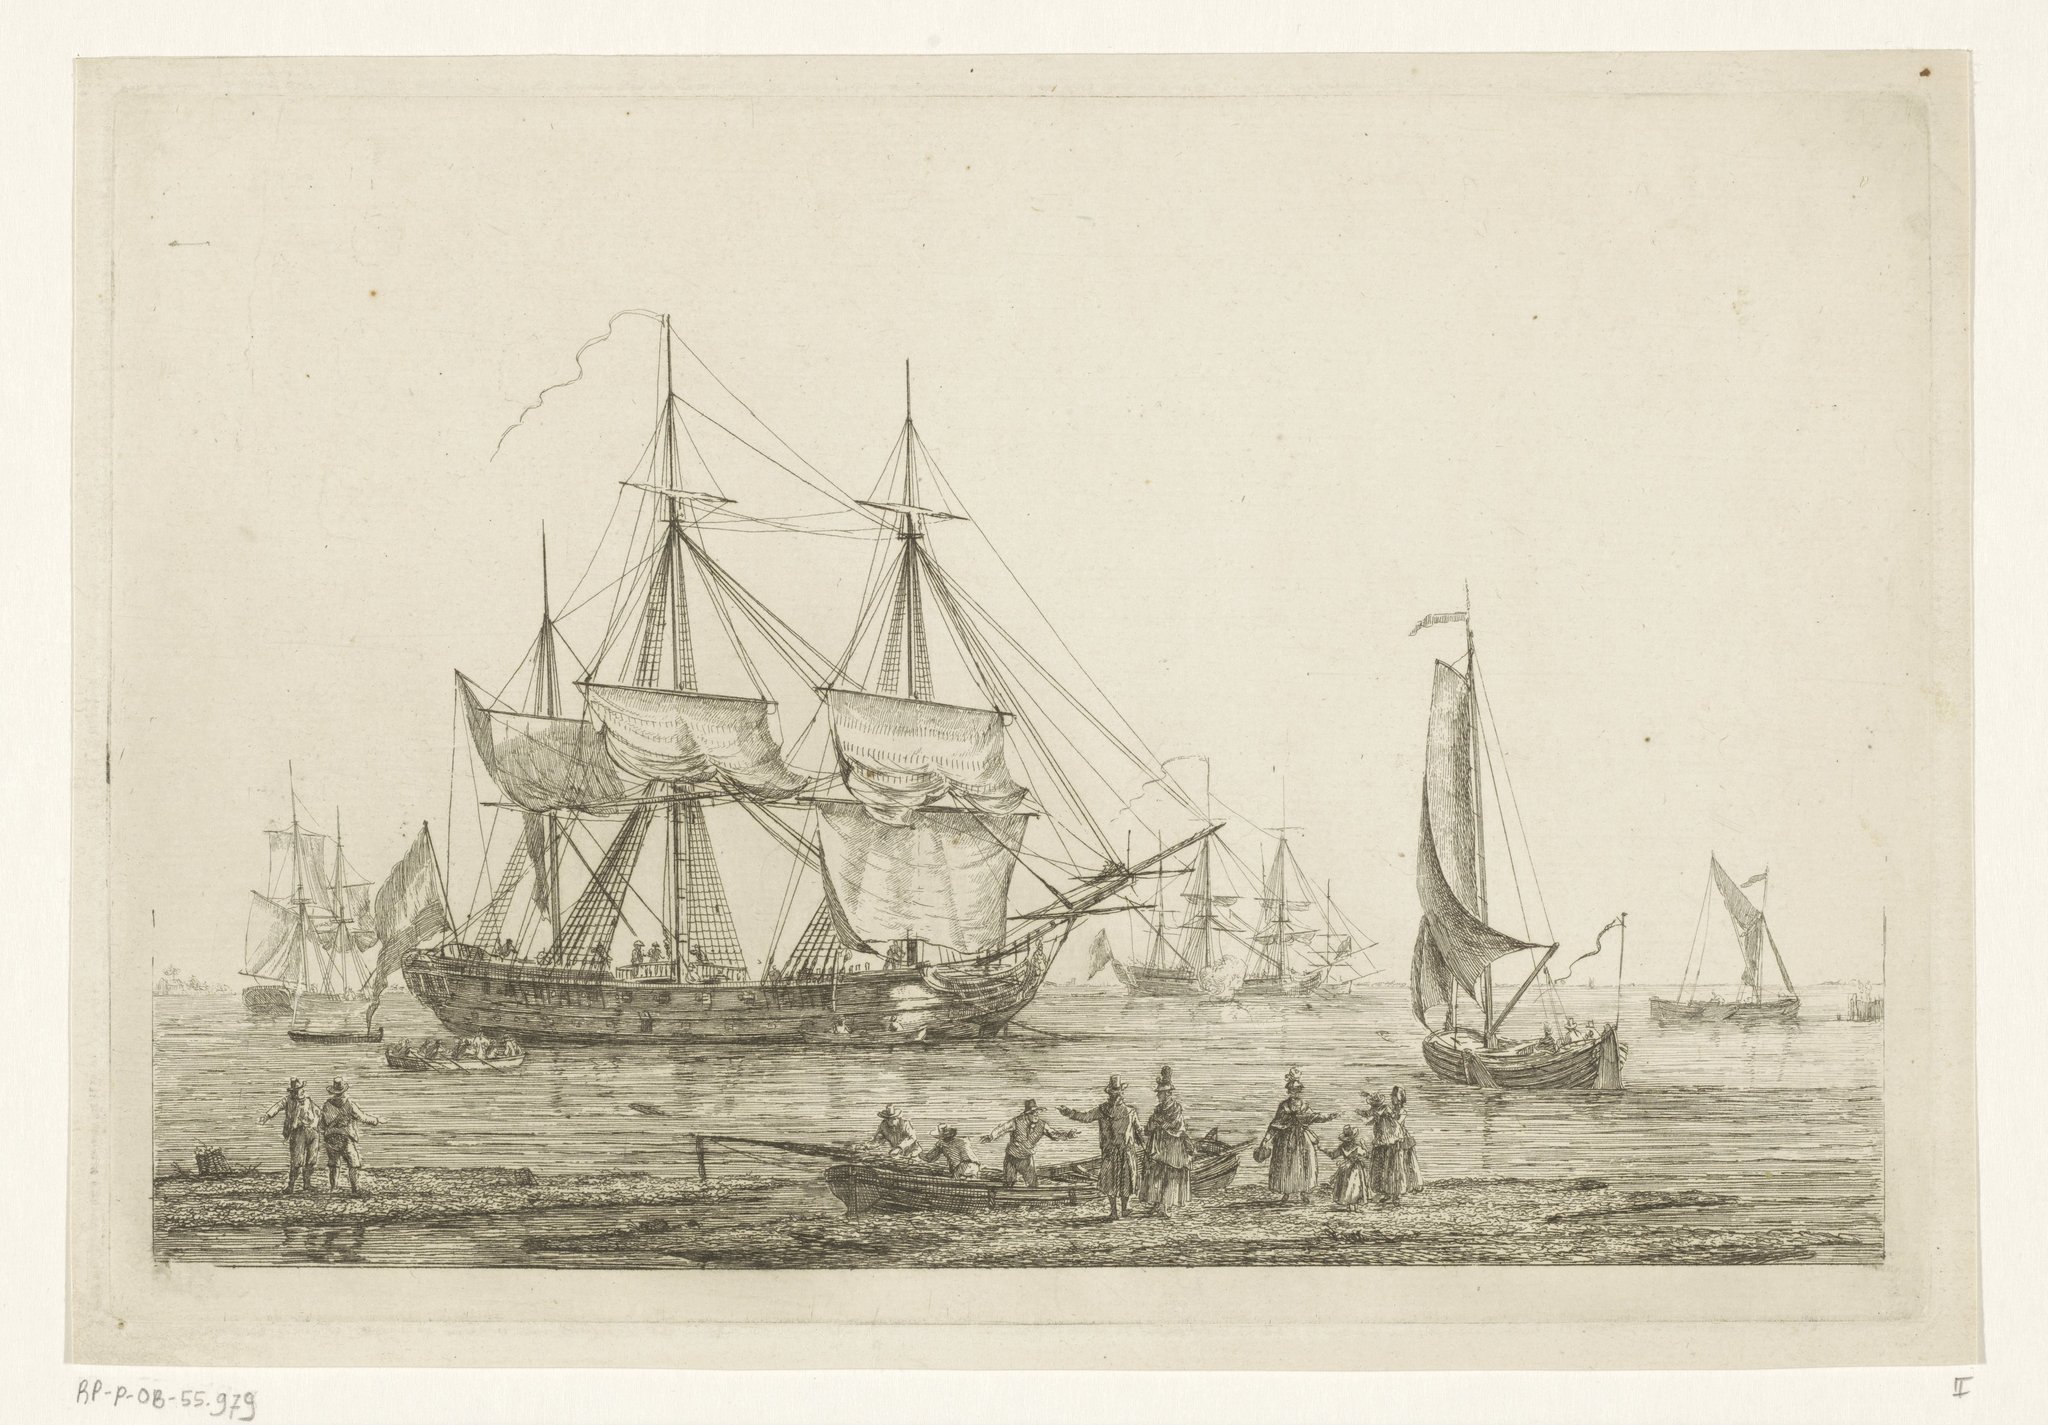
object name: print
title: Diverse schepen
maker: gerrit groenewegen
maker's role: draughtsman, print maker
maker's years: 1754-1826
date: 1793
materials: paper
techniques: printmaking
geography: rotterdam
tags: ships (in general)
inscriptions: collector's mark: Lugt 2228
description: Twee driemasters en andere schepen in de buurt van de wal. Op de voorgrond zijn elf figuren te zien, waarvan er drie in een sloep zijn afgebeeld. Deze prent maakt deel uit van een serie van vijf prenten met verschillende schepen op open water.